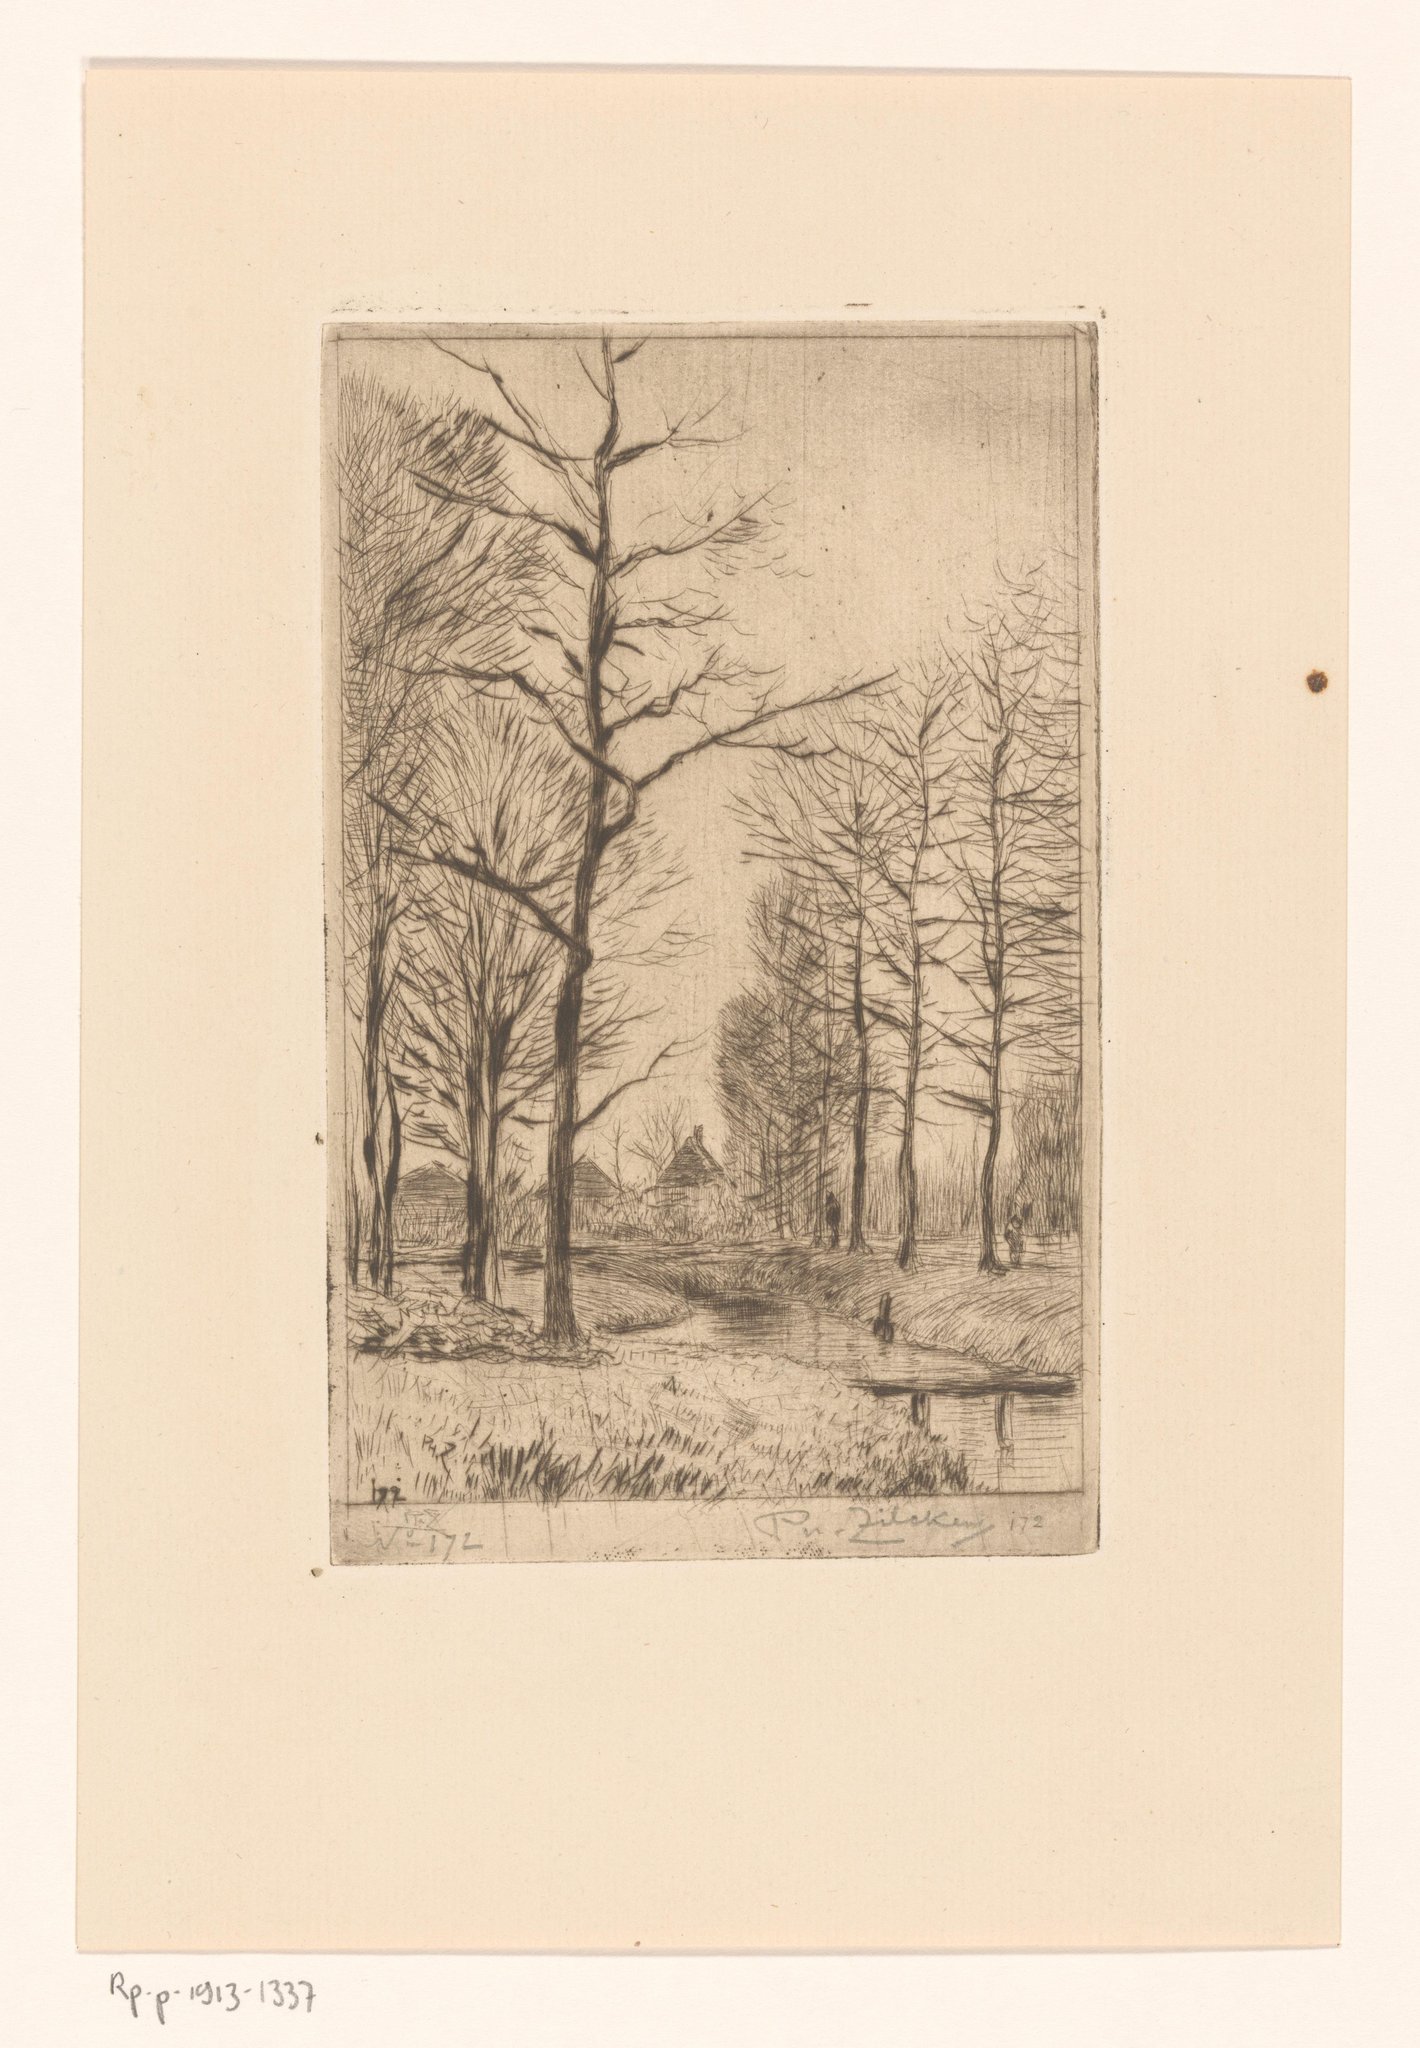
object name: print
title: Landschap met huizen, bomen en beek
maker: philip zilcken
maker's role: draughtsman, painter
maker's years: 1857-1930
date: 1867-1890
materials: paper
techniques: drypoint, etching, intaglio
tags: trees, rural housing, e.g. country-house, villa, cottage, brook, the hague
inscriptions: collector's mark: Lugt 2233